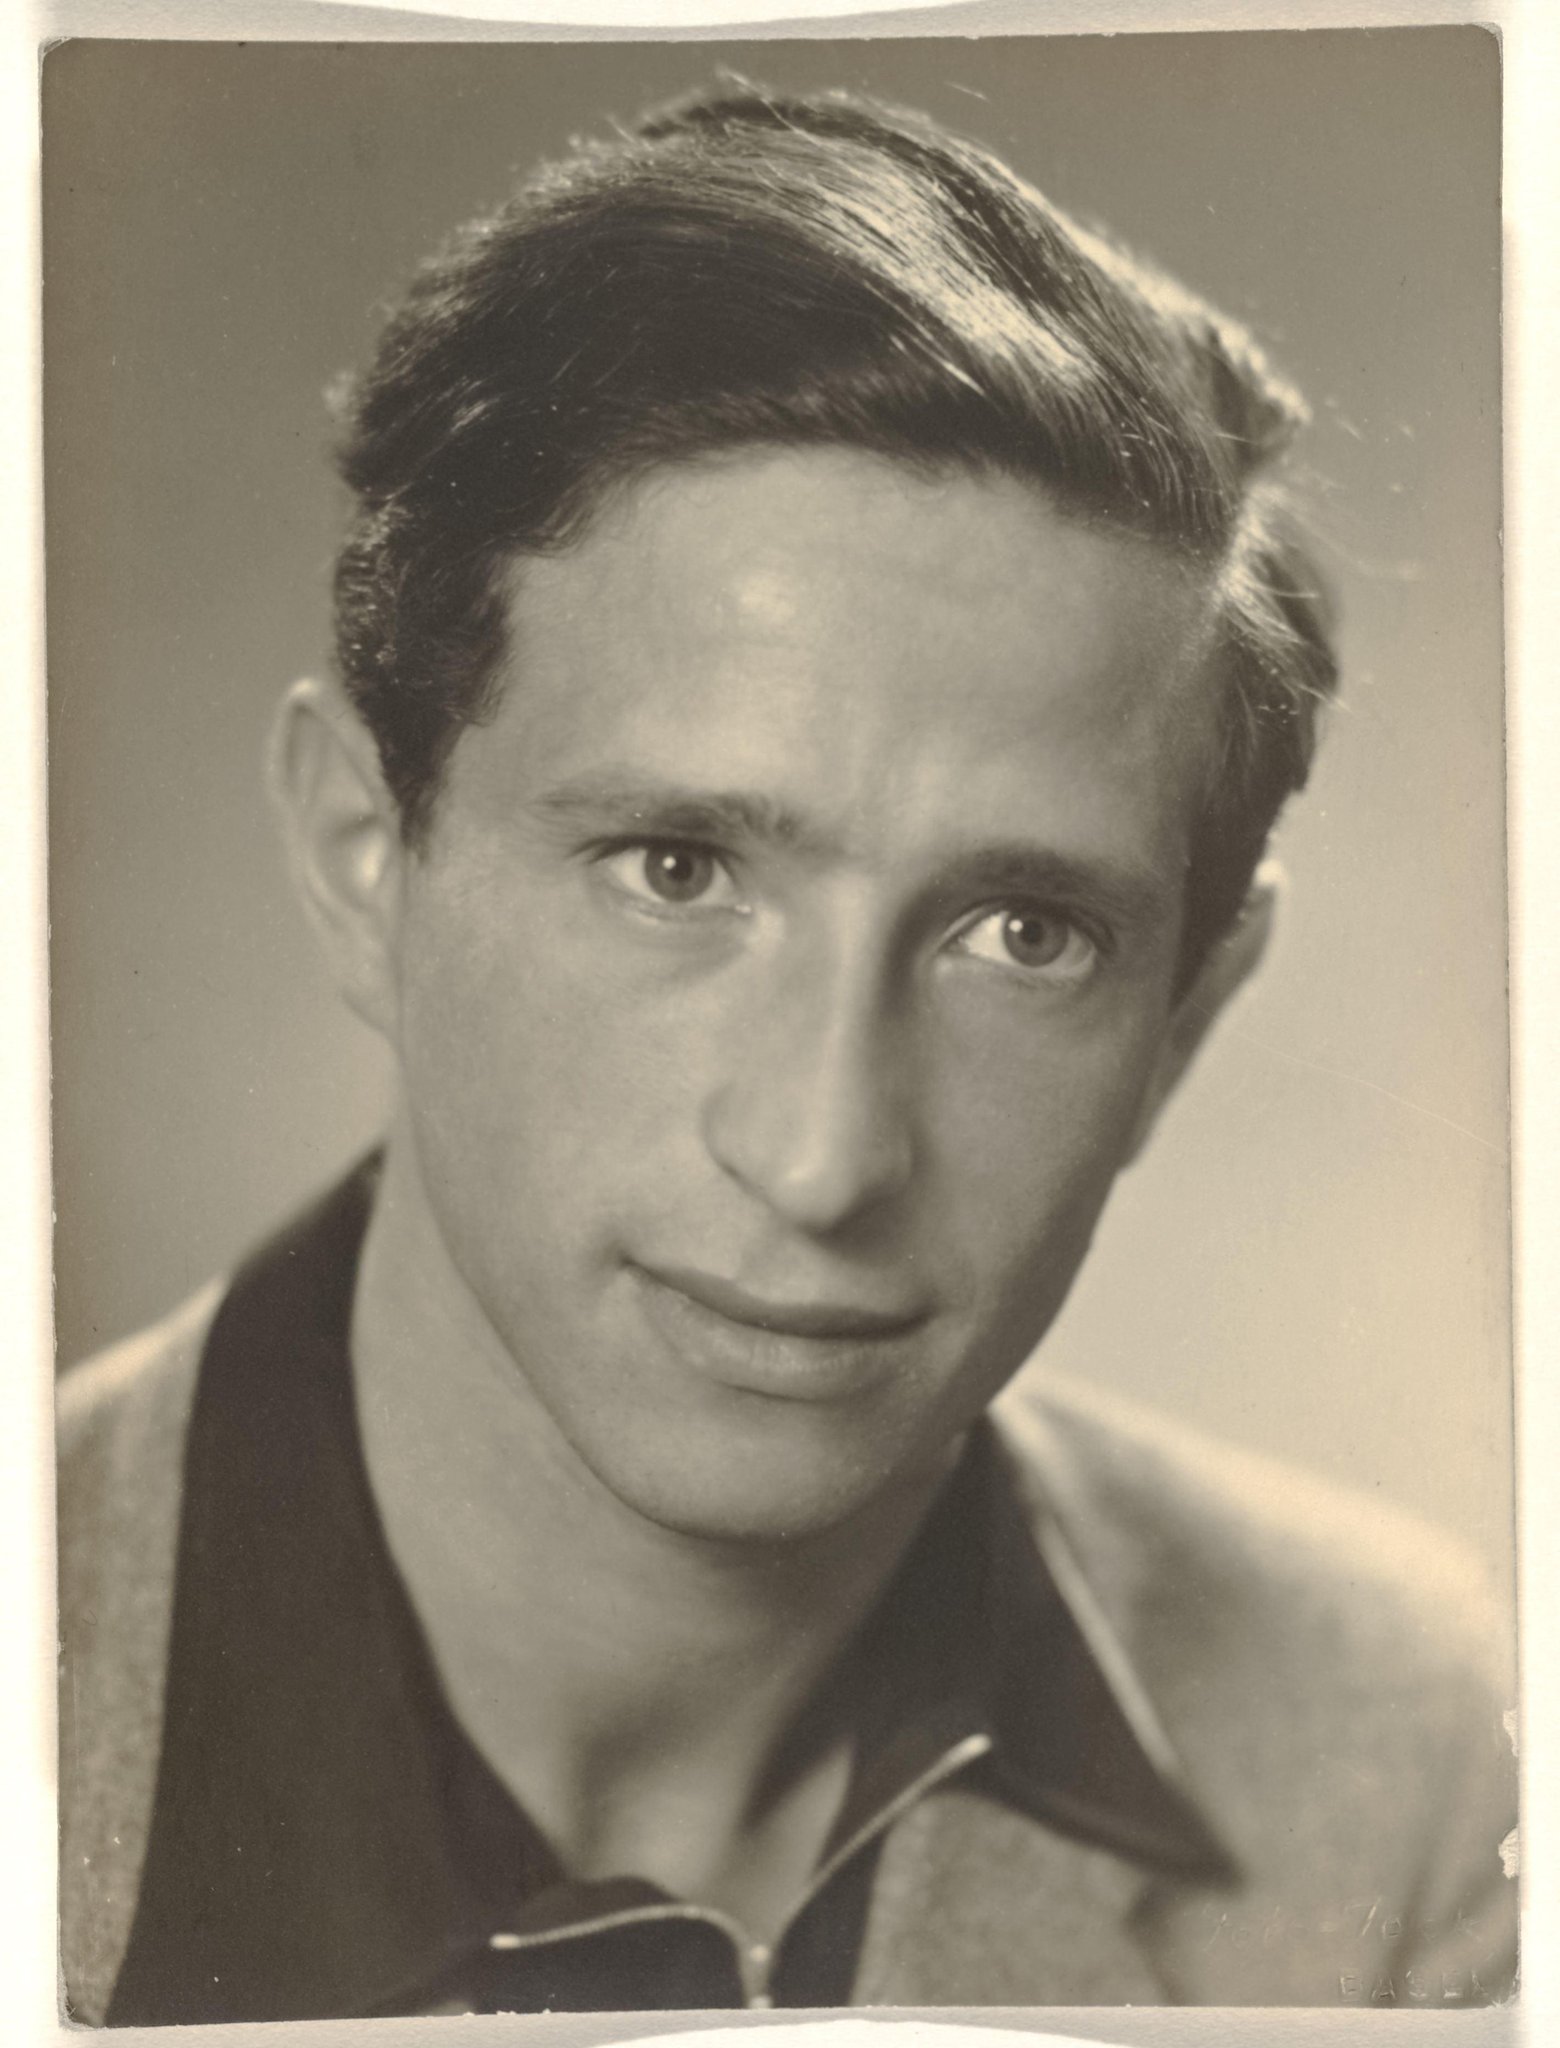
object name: photograph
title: Portret van Leo Blumensohn, de eerste echtgenoot van Isabel Wachenheimer, 1945-1949, Zwitserland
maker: Anonymous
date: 1945-1949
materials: photographic support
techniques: gelatin silver print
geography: switzerland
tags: switzerland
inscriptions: inscription: ‘(?) wie! Denk an unsere liebe und an unsere zukunft, die sich so gestattet wie wir es wollen. In liebe, Dein Leo’